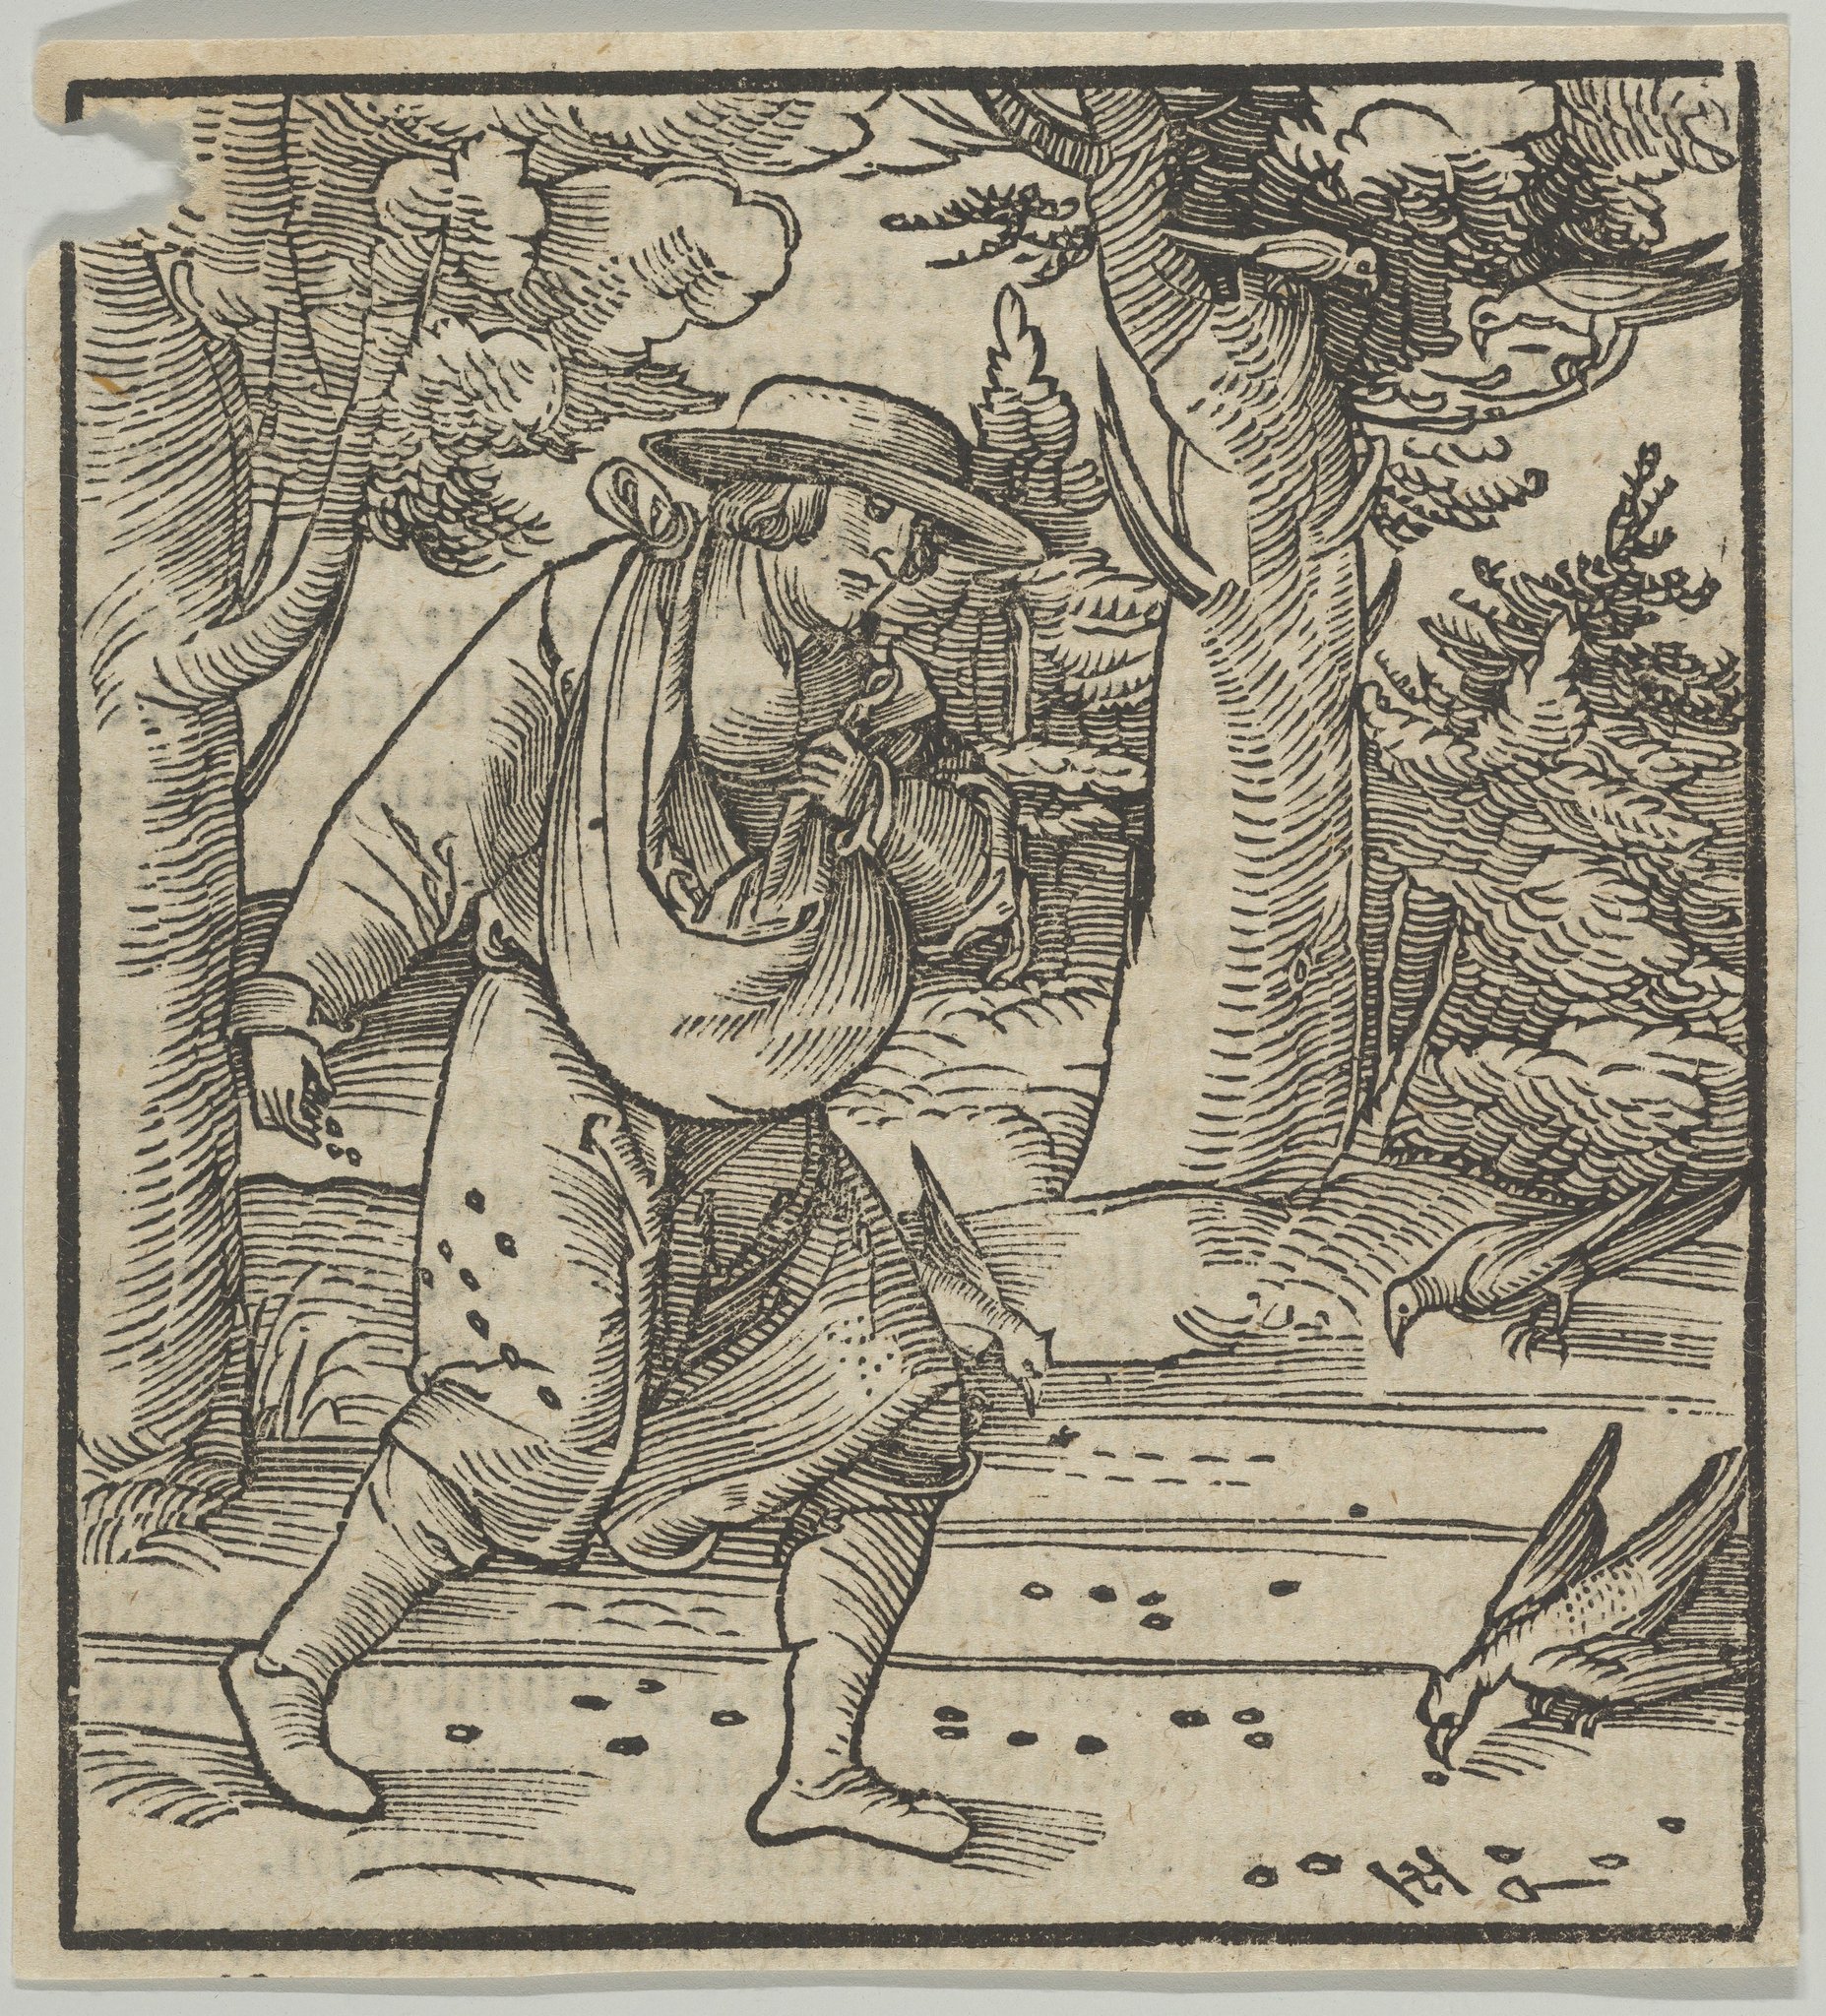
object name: print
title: The Birds Eating the Seeds of the Sower, from Hymmelwagen auff dem, wer wol lebt...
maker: hans schäufelein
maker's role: artist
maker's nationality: german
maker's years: 1480-1540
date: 1517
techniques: woodcut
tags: birds,men